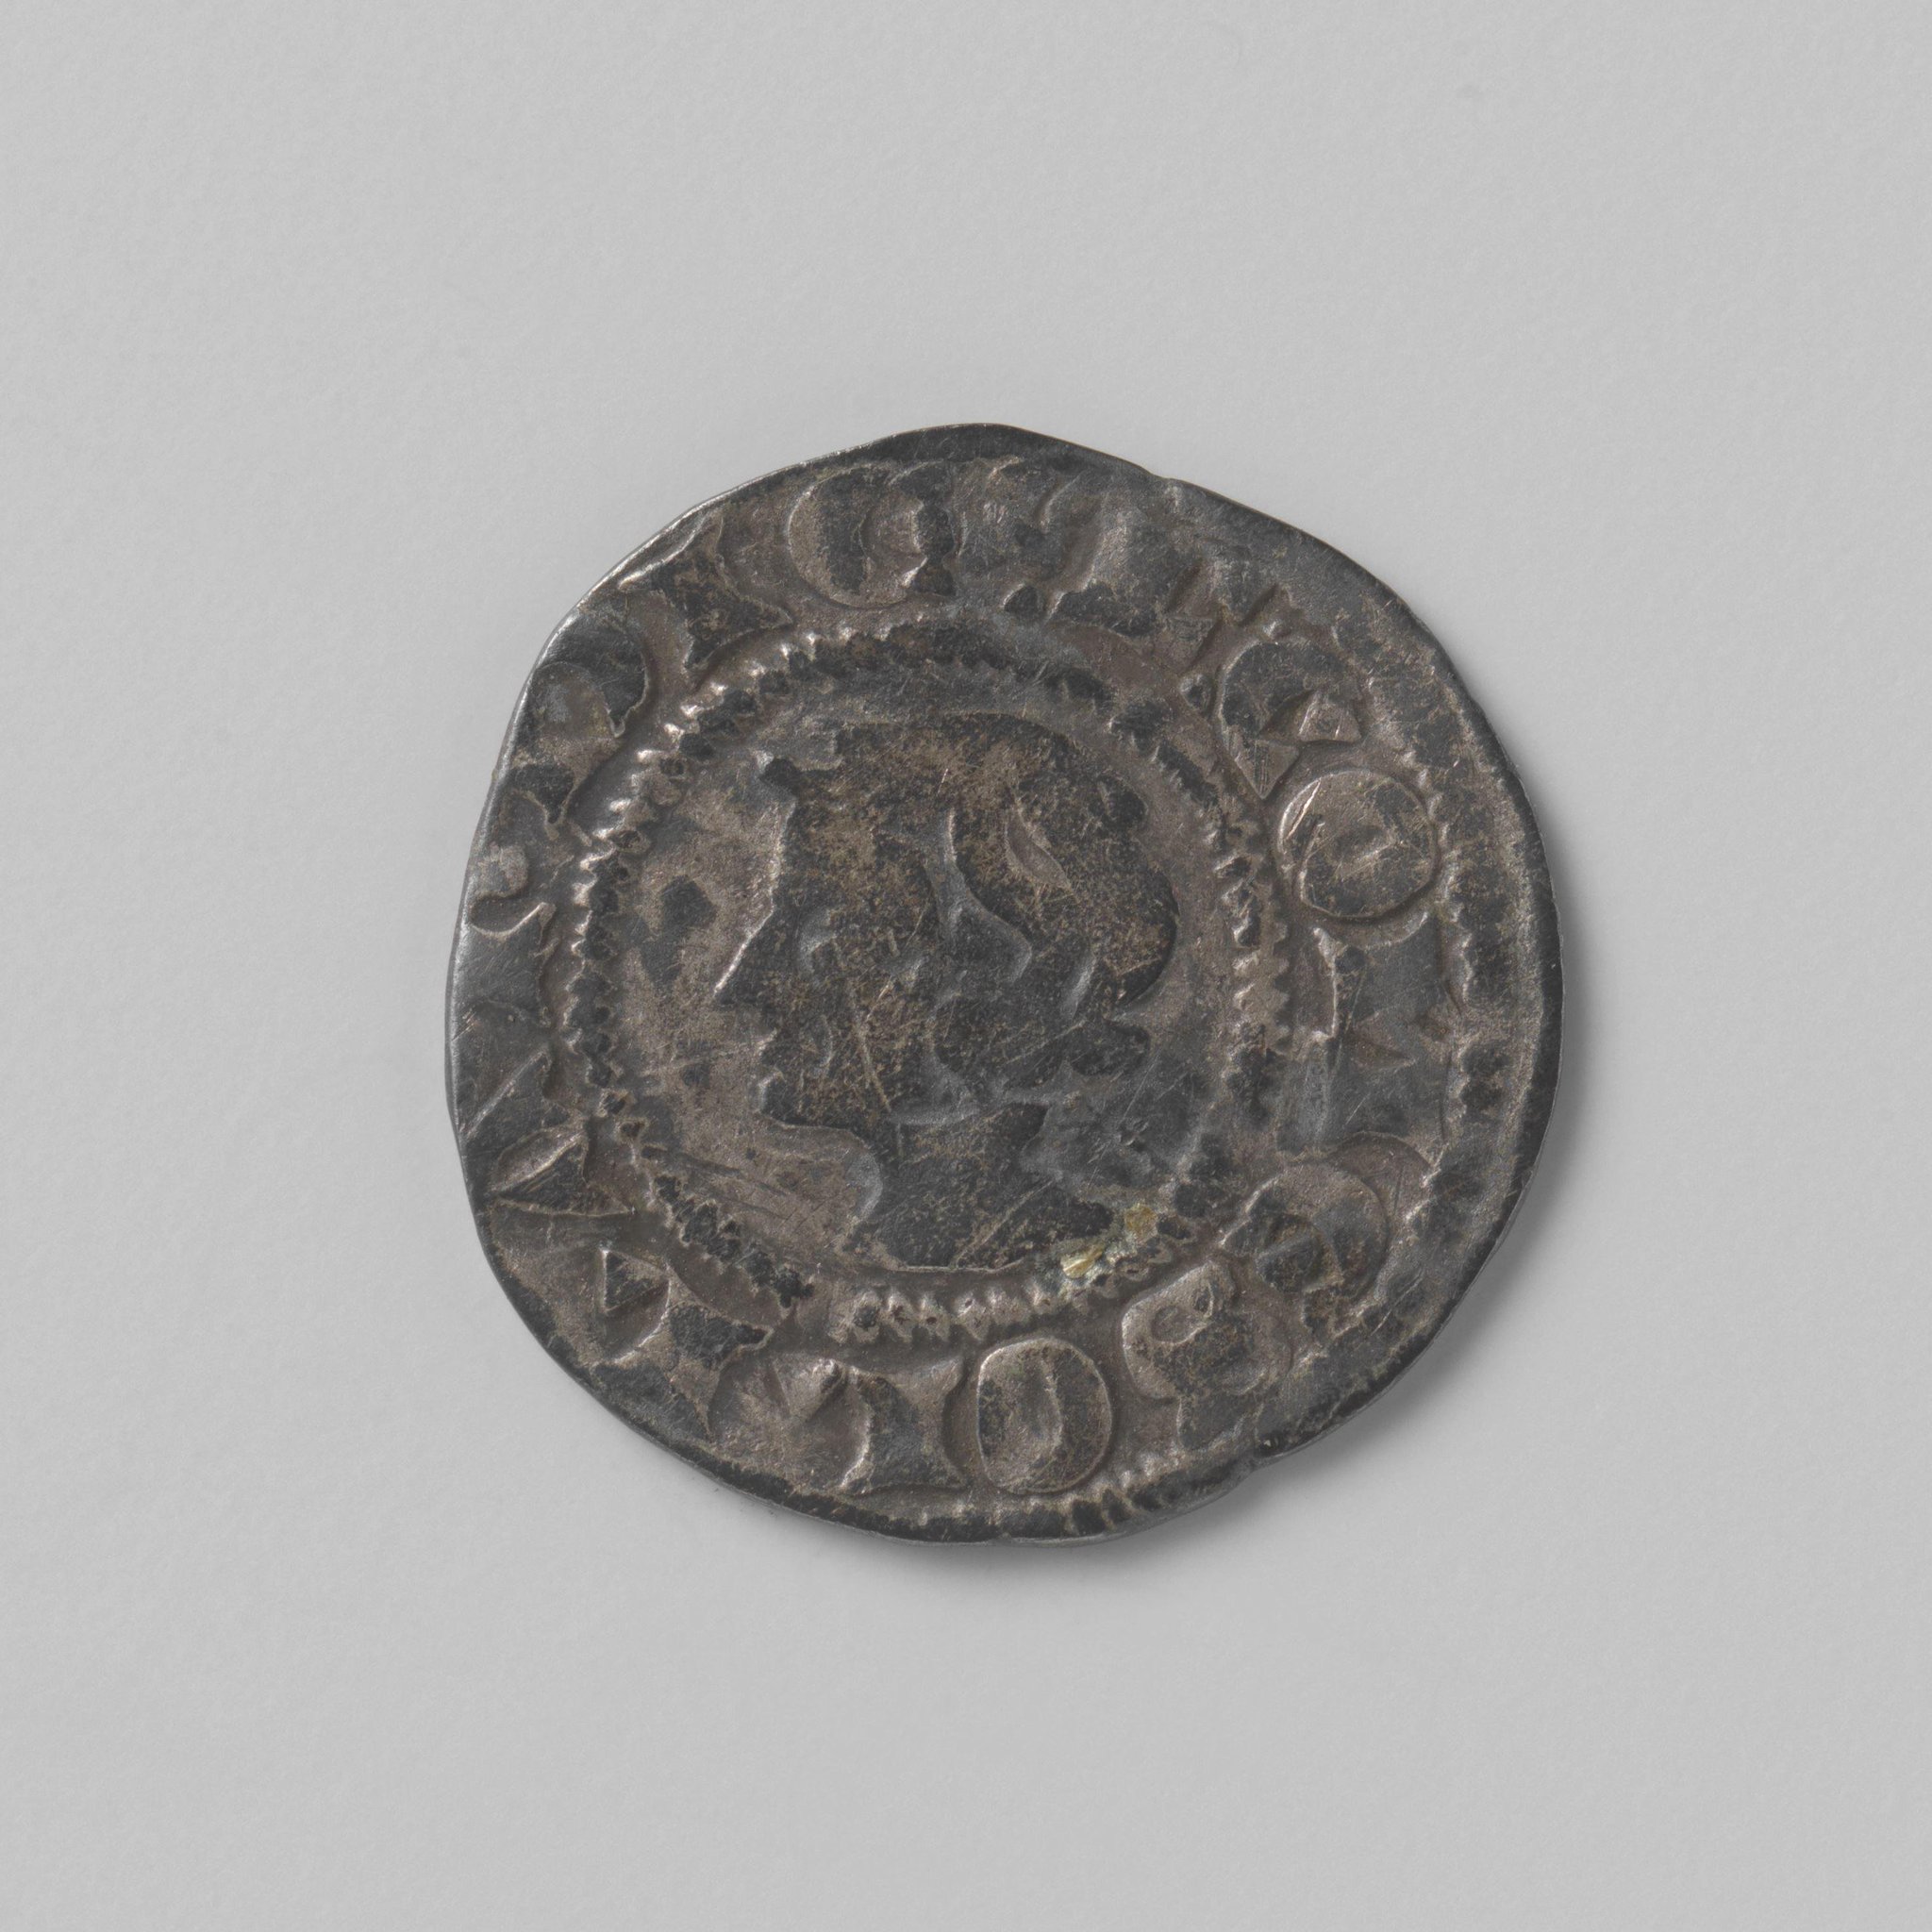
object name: penny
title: Hollandse penning van Floris V, 1256-1296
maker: floris v (graaf van holland en zeeland)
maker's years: 1254-1296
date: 1293-1296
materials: silver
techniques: striking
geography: dordrecht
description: Zilveren munt. Voorzijde: hoofd zonder gravenmuts naar links. Keerzijde: lang glad kruis, in hoeken roosjes.